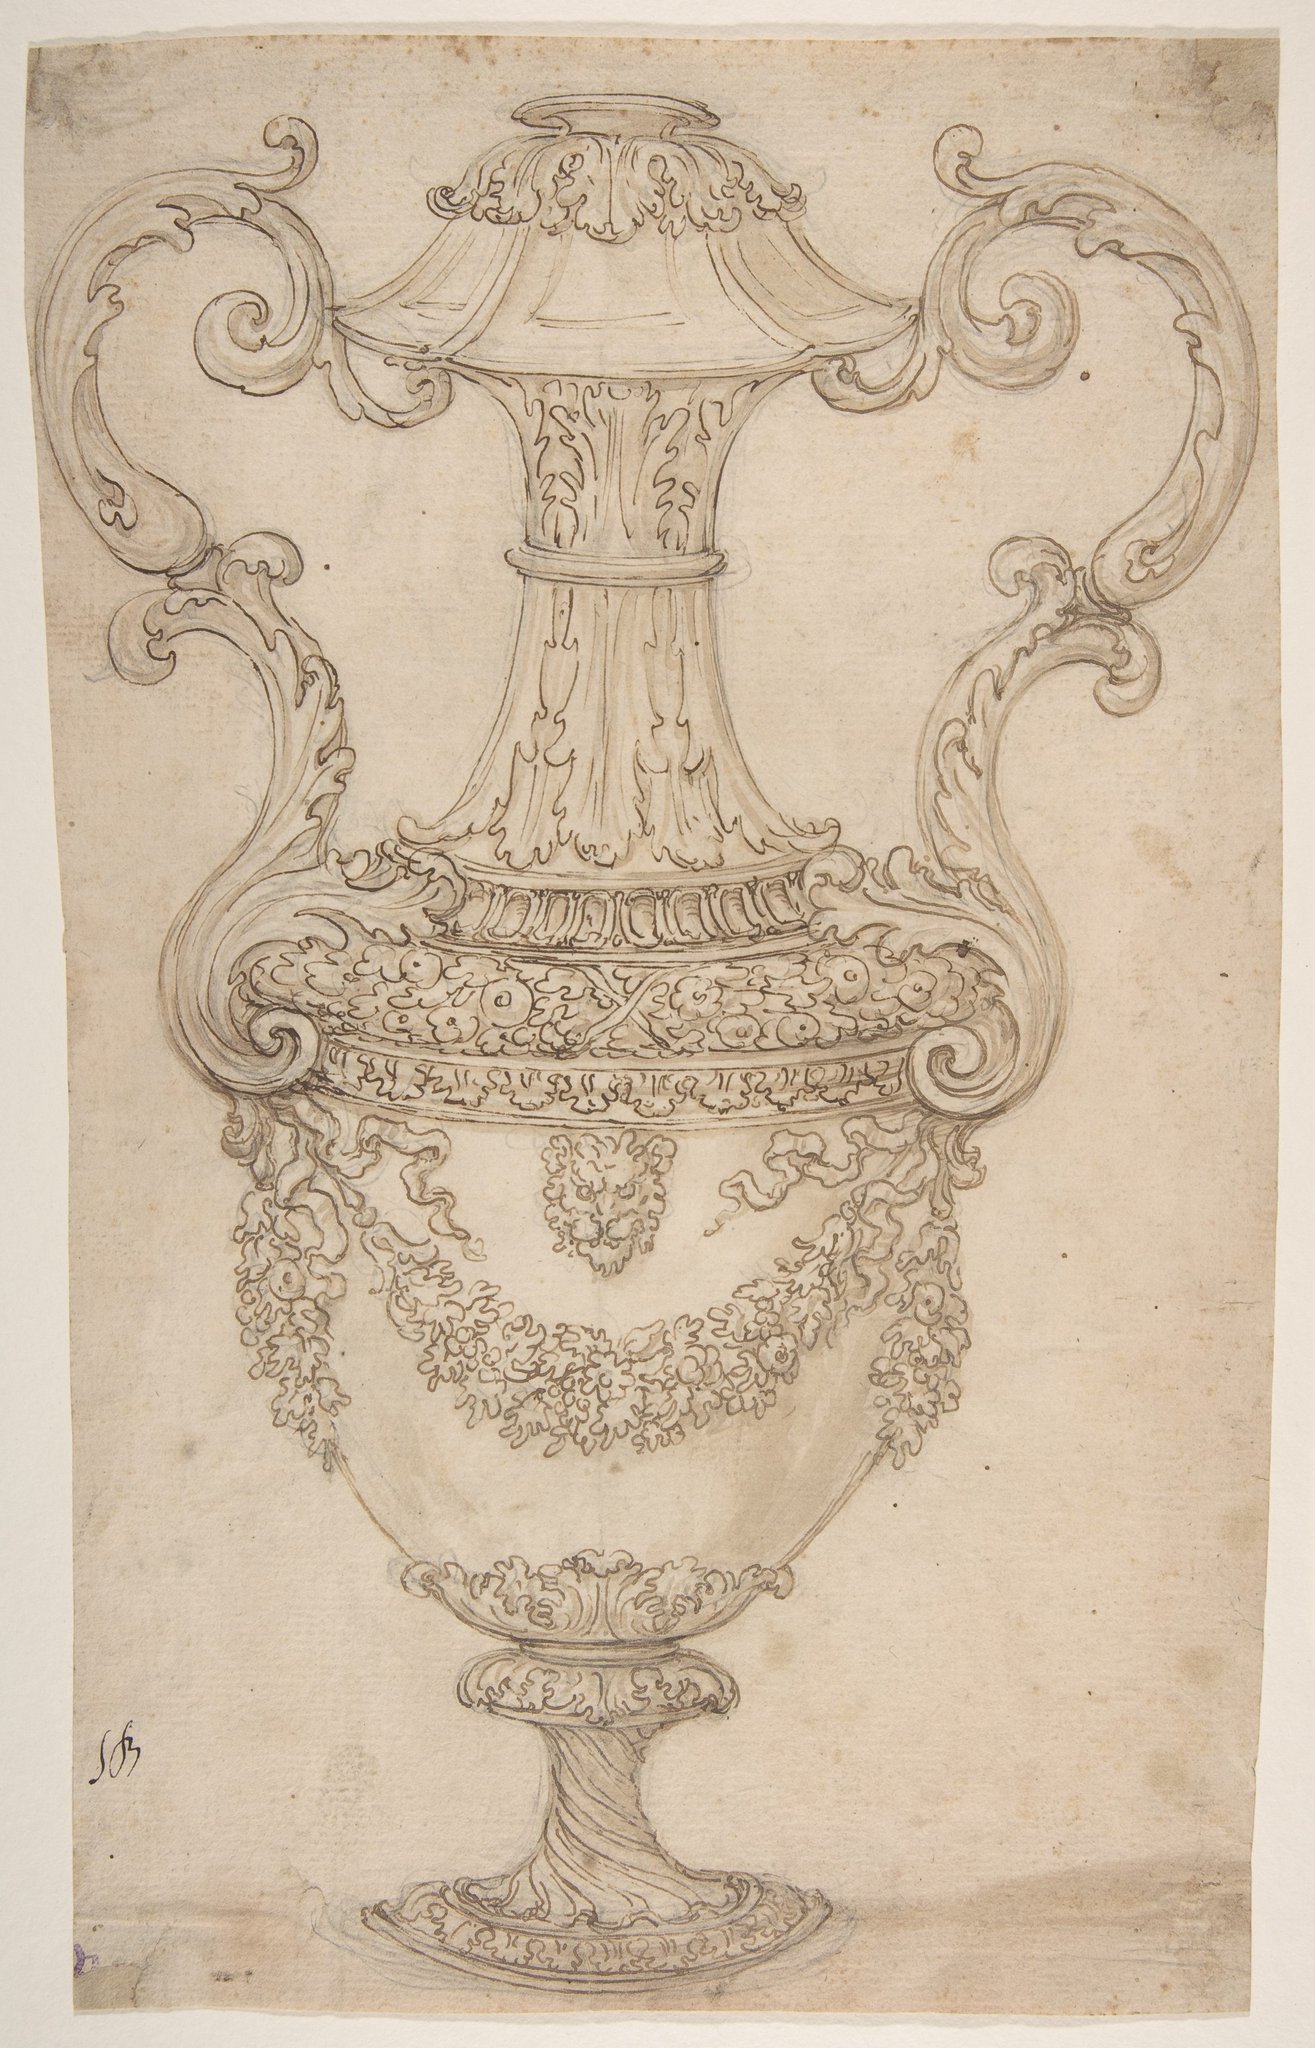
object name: drawing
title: Design for a Vase with Handles, Decorated with a Festoon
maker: giovanni battista foggini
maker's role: artist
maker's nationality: italian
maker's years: 1652-1725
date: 1672-1725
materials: graphite, ink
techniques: brush, pen, wash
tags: garlands,vases